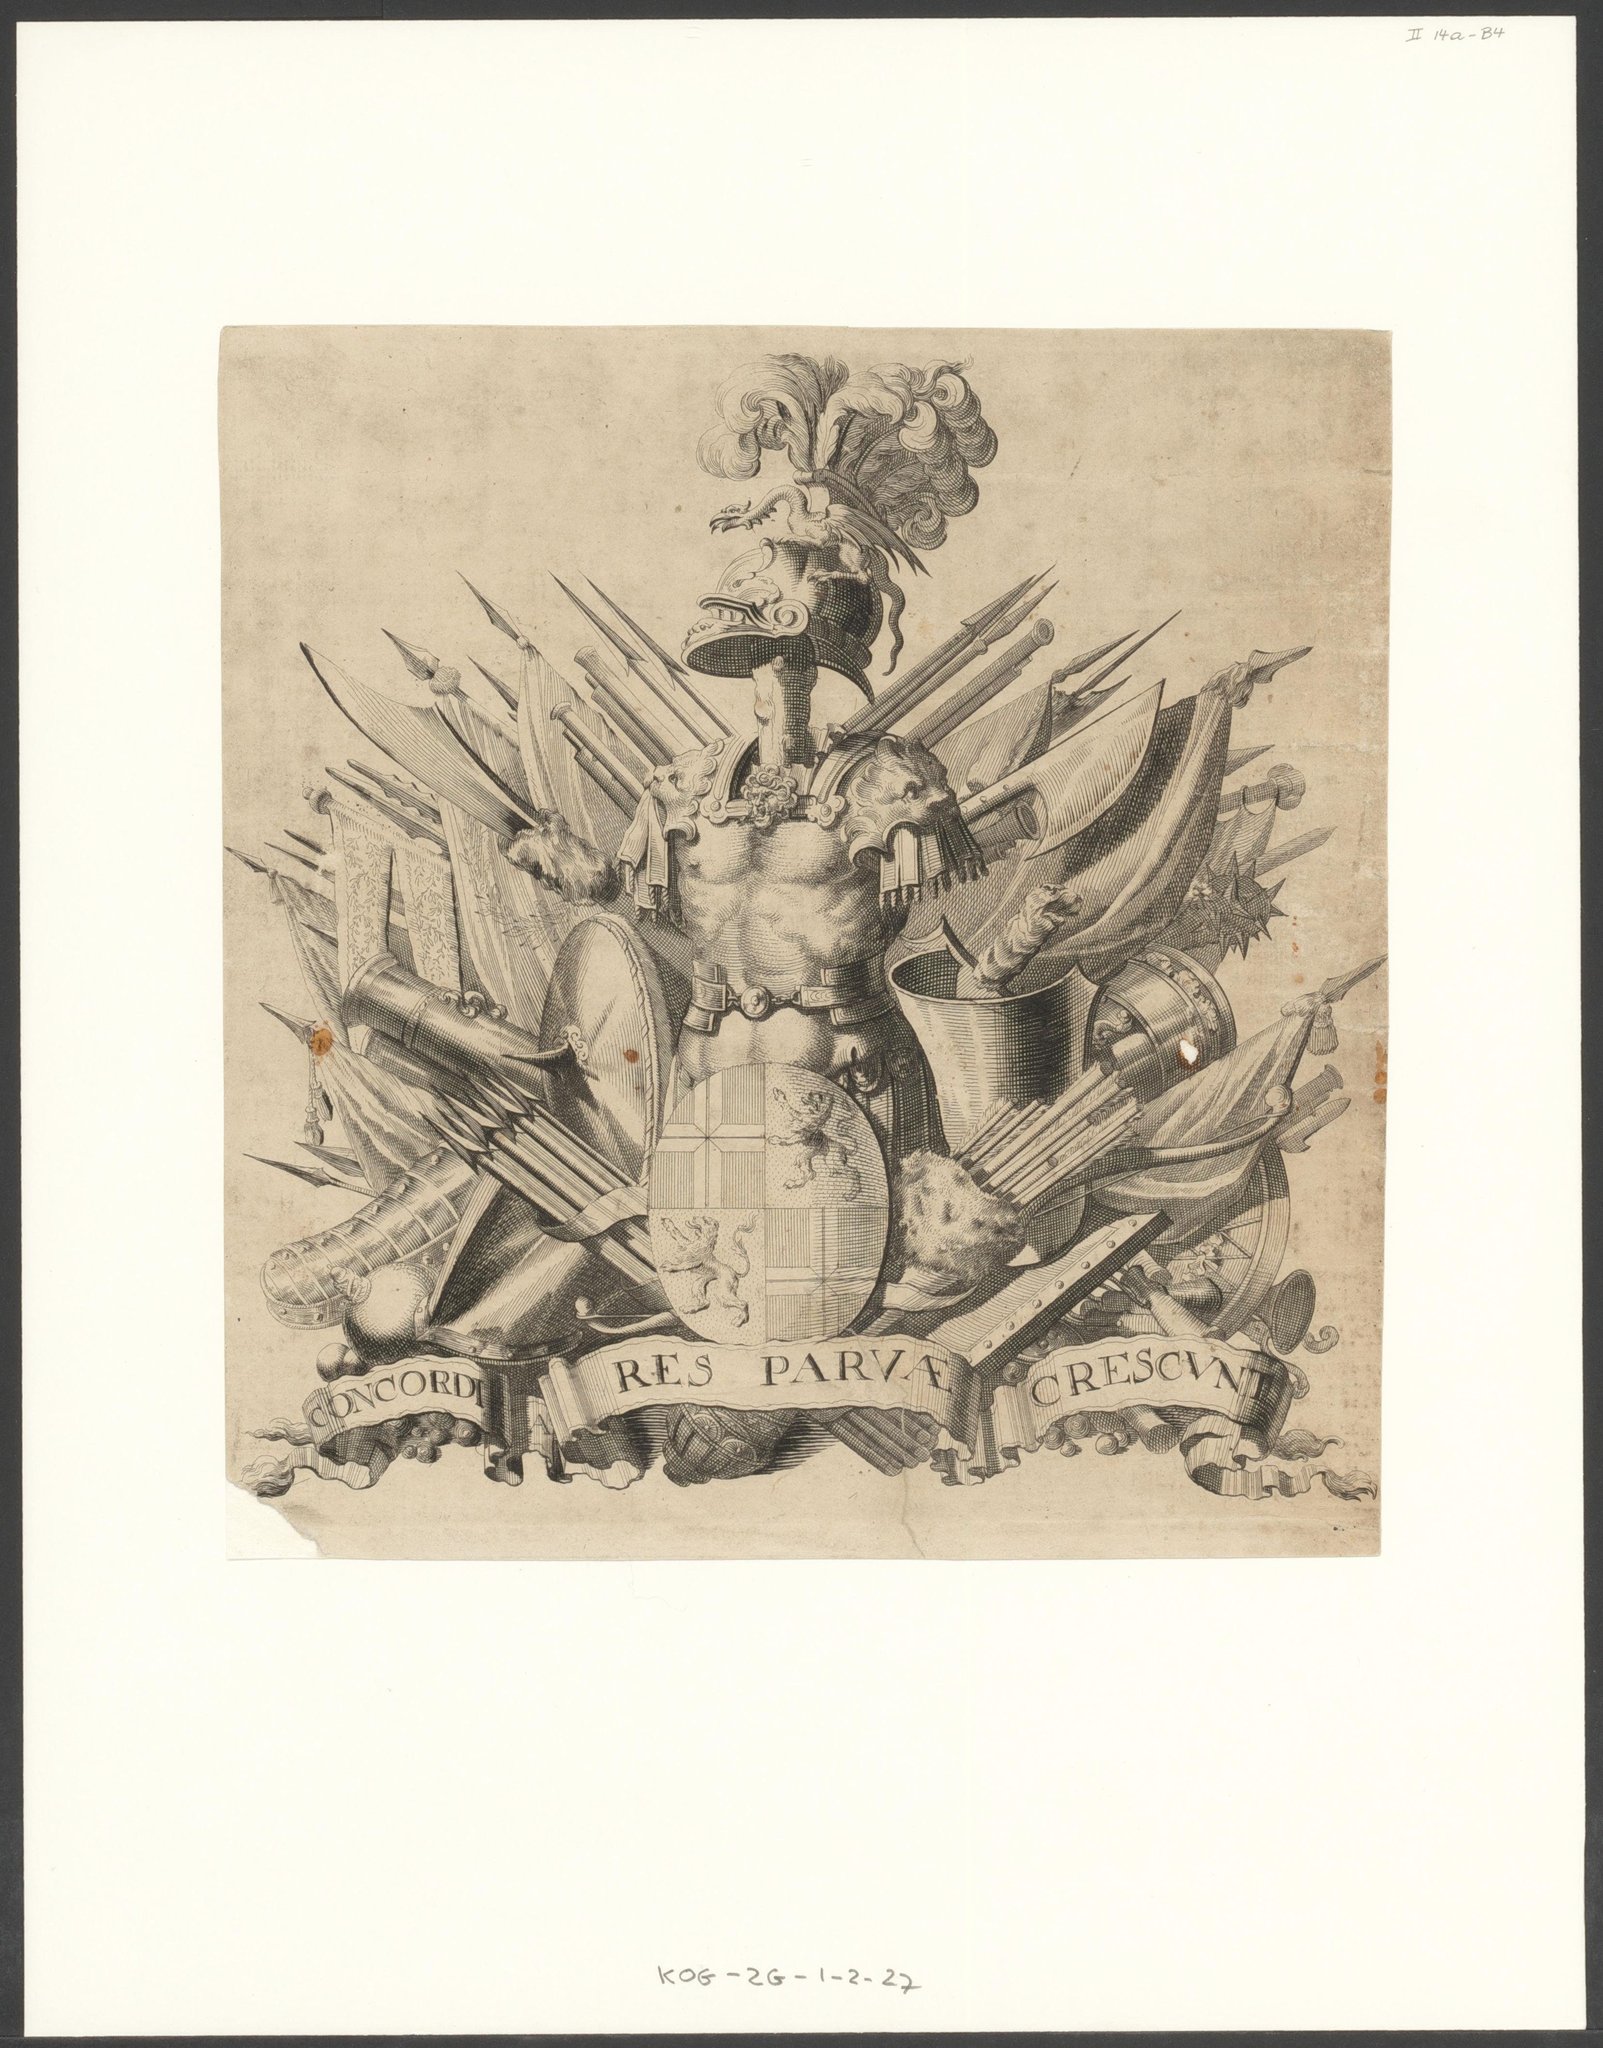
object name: print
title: Wapen van Utrecht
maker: Anonymous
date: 1700-1799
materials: paper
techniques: engraving, etching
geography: netherlands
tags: 'tropaion', i.e. decorative ornament ~ weapons, coat of arms (as symbol of the state, etc.) (+ province; provincial)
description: Wapen van de provincie Utrecht, in het midden van een wapentrofee. Onderaan de wapenspreuk. Onderwerpsrubrieken binnen de Atlas Zeden en Gewoonten: Regeering, Wapens, Heraldiek, Gewesten.